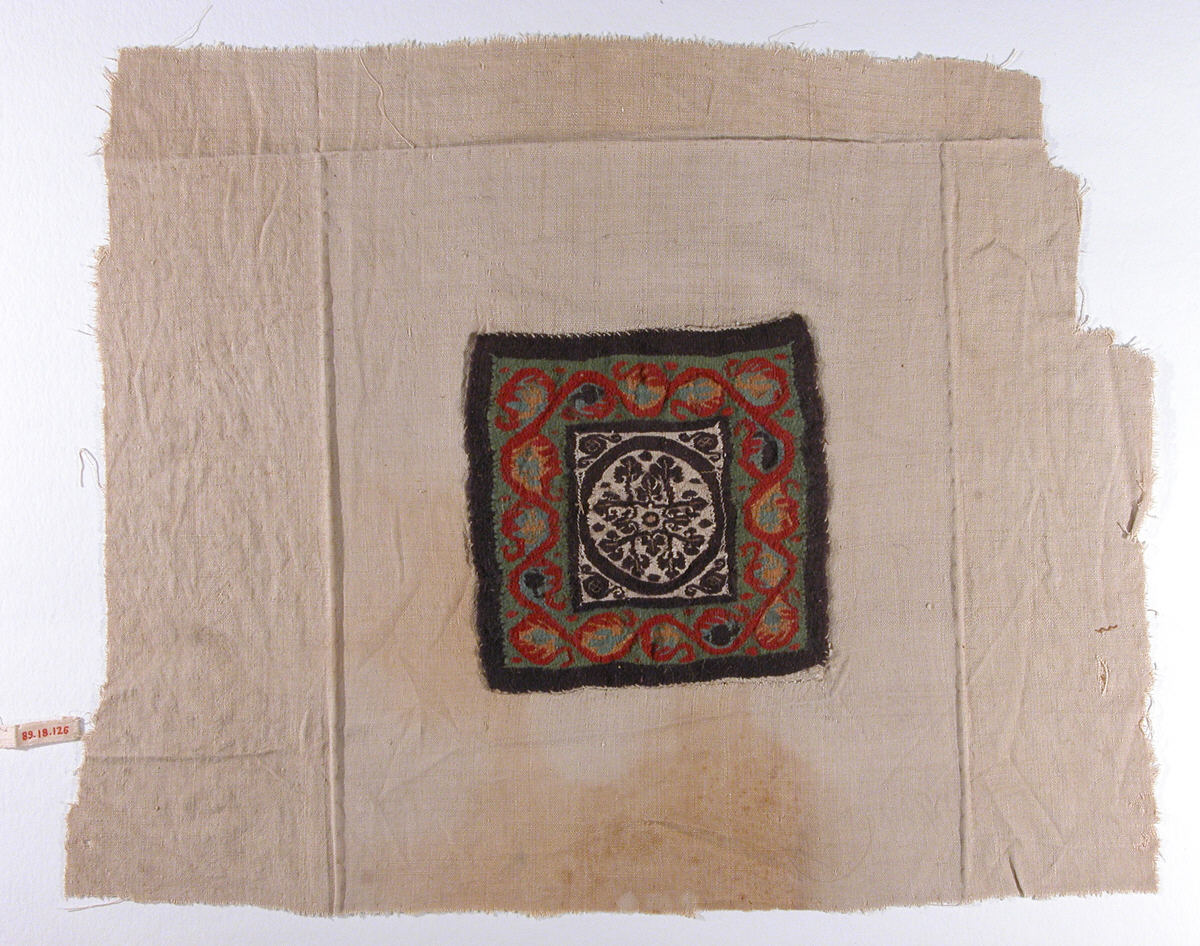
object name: textile fragment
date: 301-400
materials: linen, wool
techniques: weave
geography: egypt